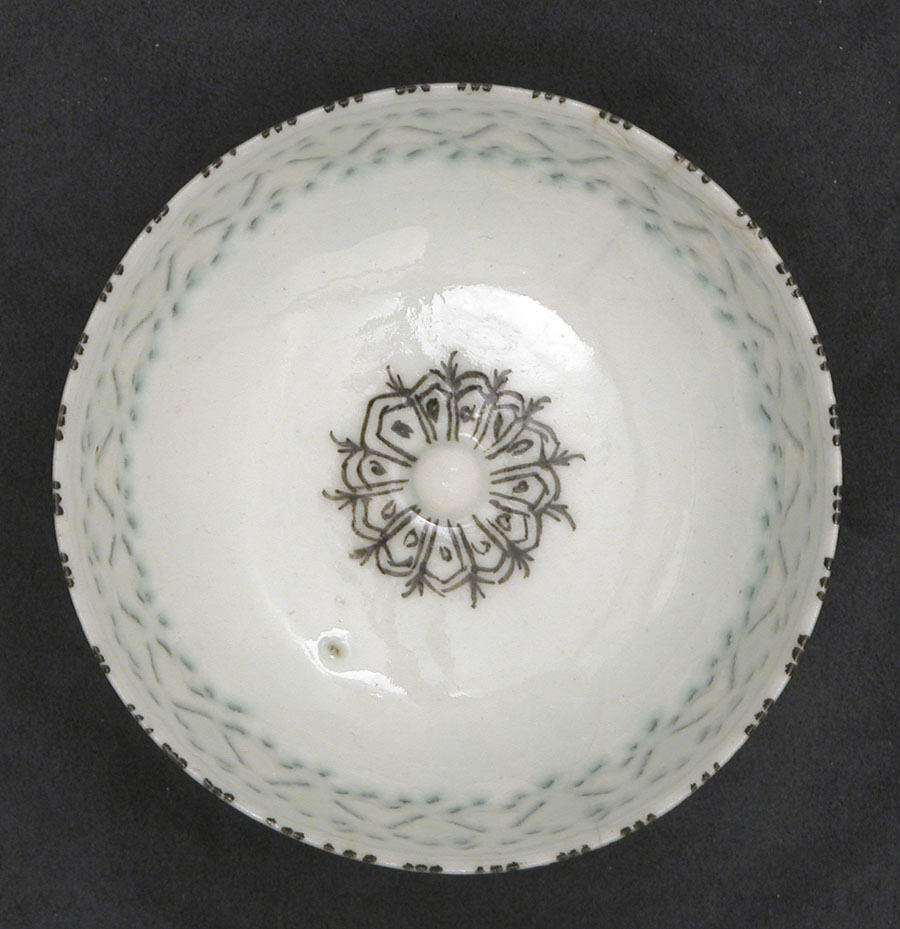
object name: bowl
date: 1701-1750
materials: glaze, stonepaste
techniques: painting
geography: iran